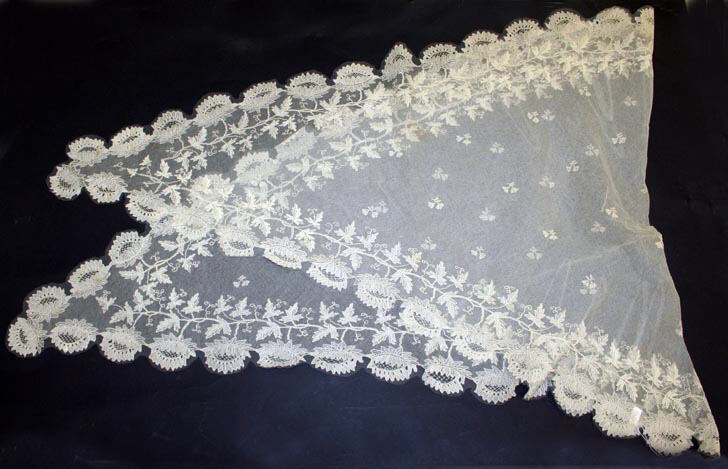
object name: fichu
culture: european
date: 1840-1849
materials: cotton